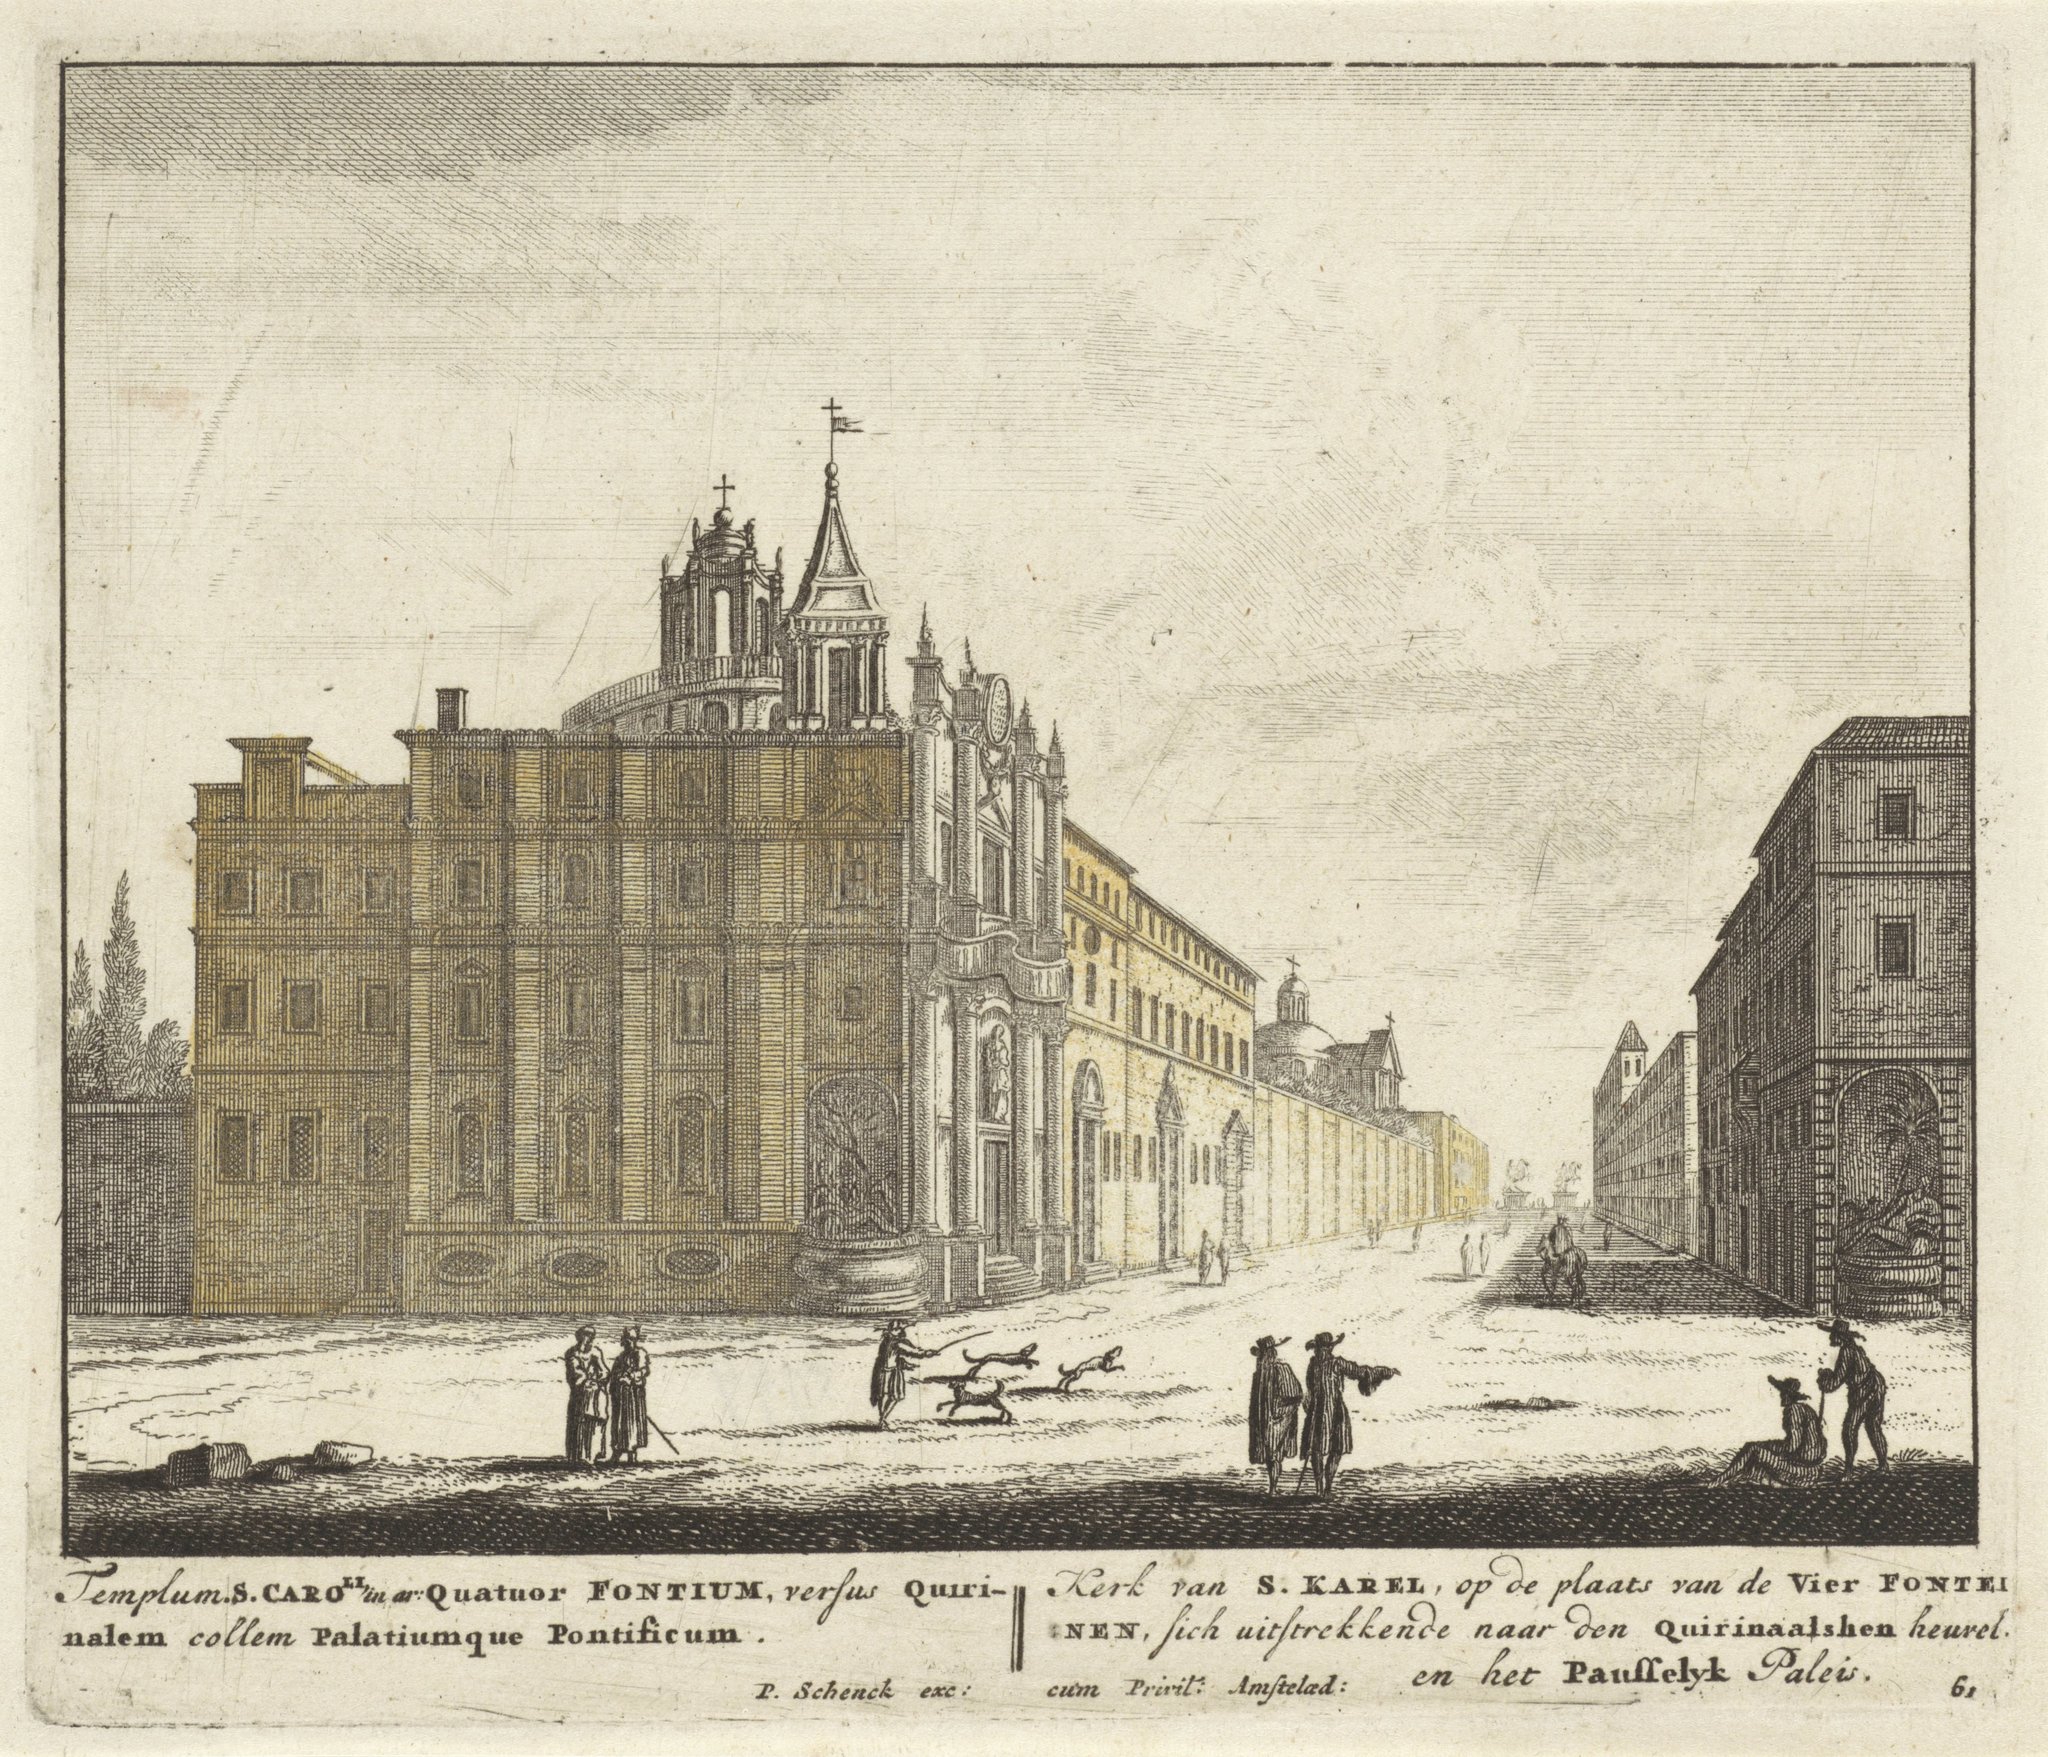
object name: print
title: Gezicht op de zijkant van San Carlo alle Quattro Fontane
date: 1675-1711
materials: paper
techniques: etching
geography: amsterdam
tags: church (exterior), dog, rome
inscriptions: collector's mark: Lugt 2228